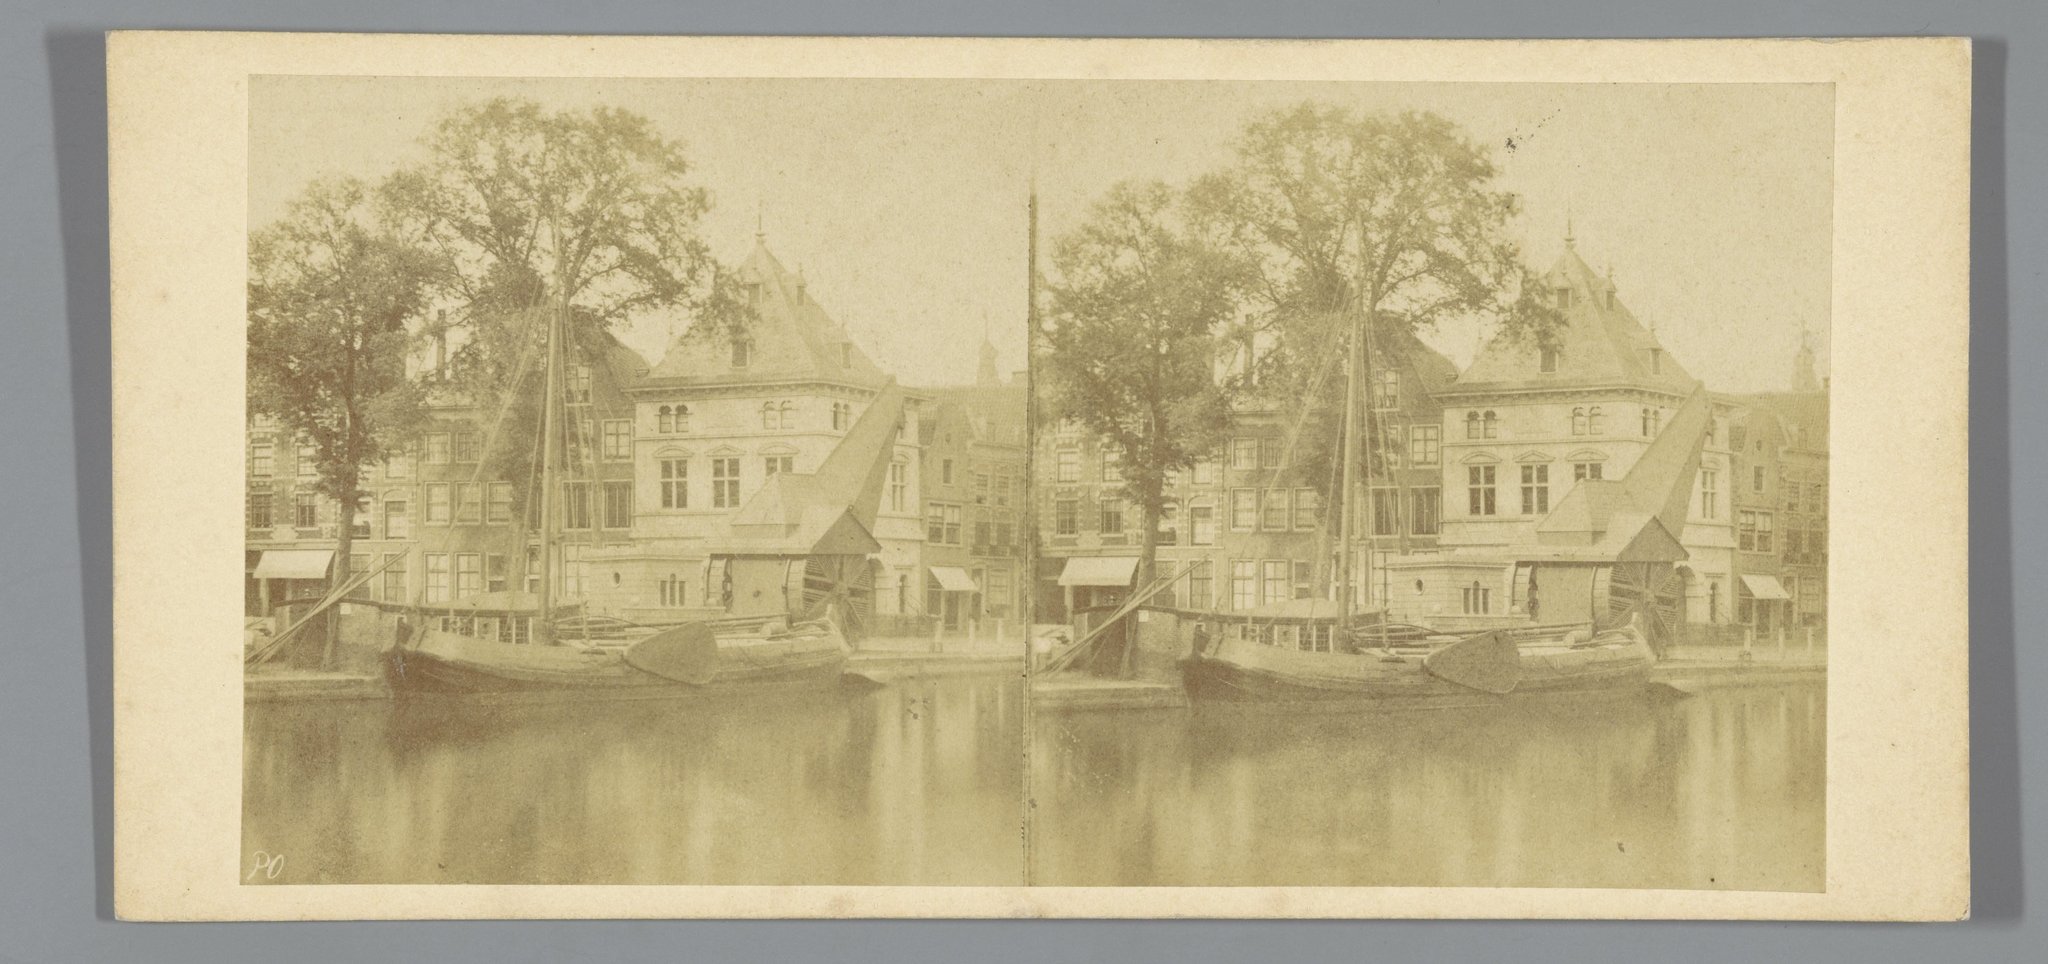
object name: stereograph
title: Spaarne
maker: pieter oosterhuis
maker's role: draughtsman, print maker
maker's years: 1816-1885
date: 1859-1865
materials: cardboard, paper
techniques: albumen print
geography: haarlem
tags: dock crane, weigh-house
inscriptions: initials: ‘P.O.’, inscription: ‘gesigneerd P(ieter) O(osterhuis)’, number: ‘No 162 163’